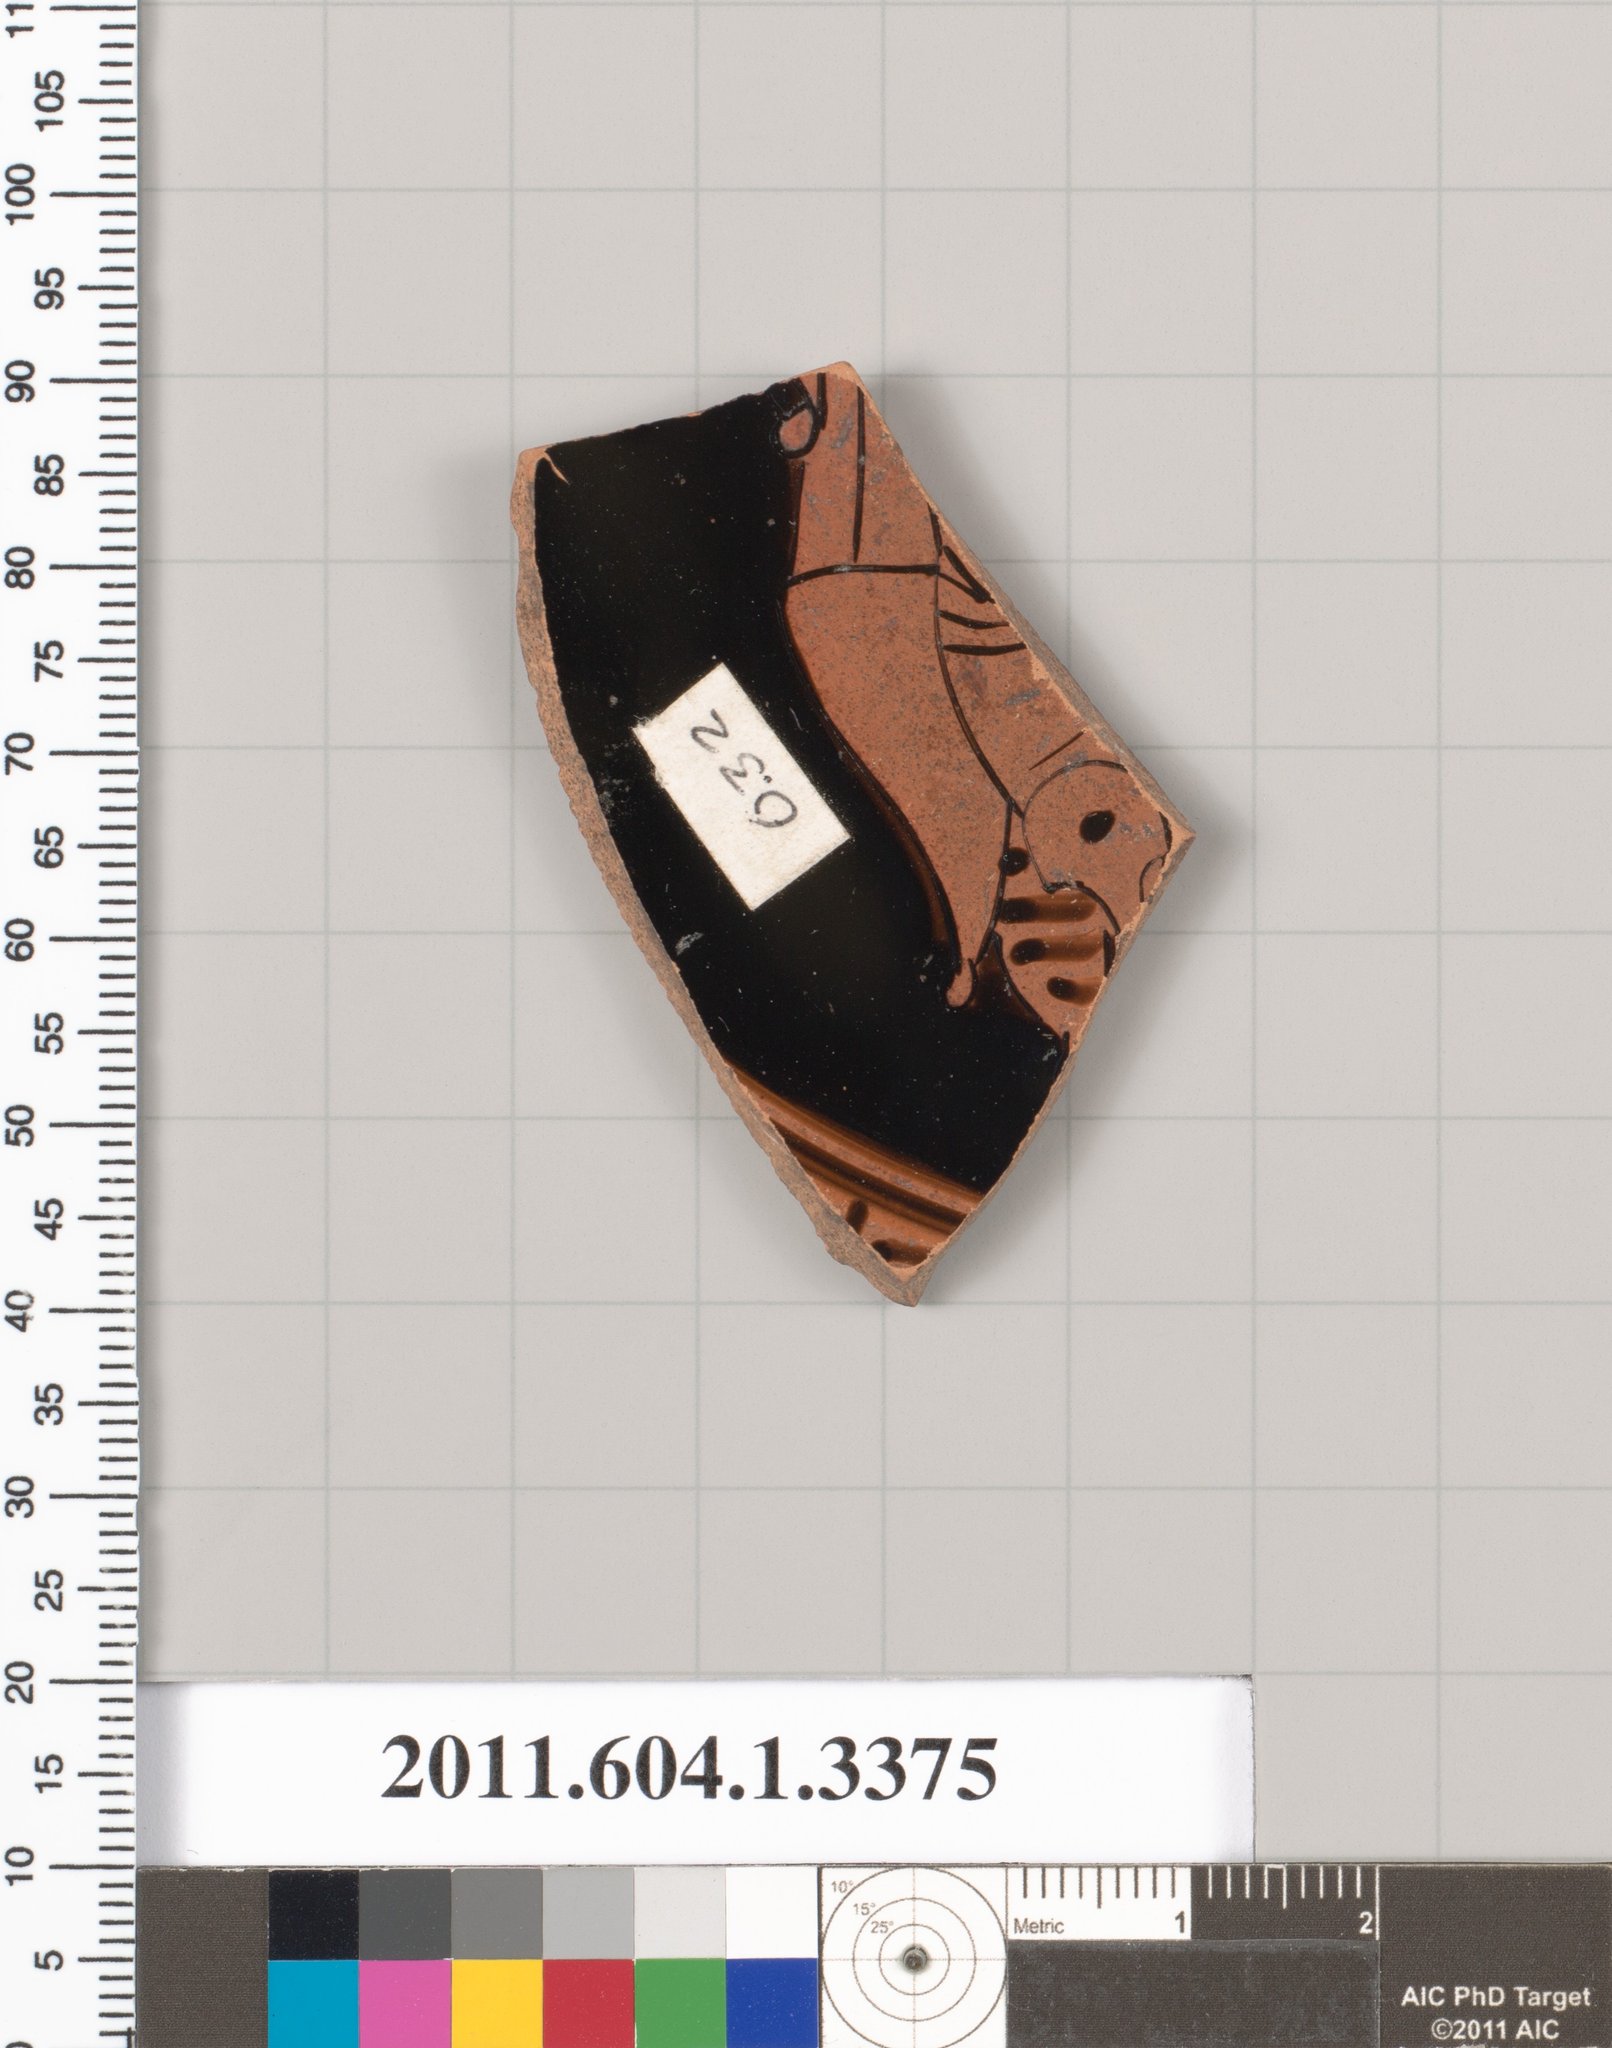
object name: kylix fragment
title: Terracotta fragment of a kylix (drinking cup)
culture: greek, attic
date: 475-451 BCE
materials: terracotta